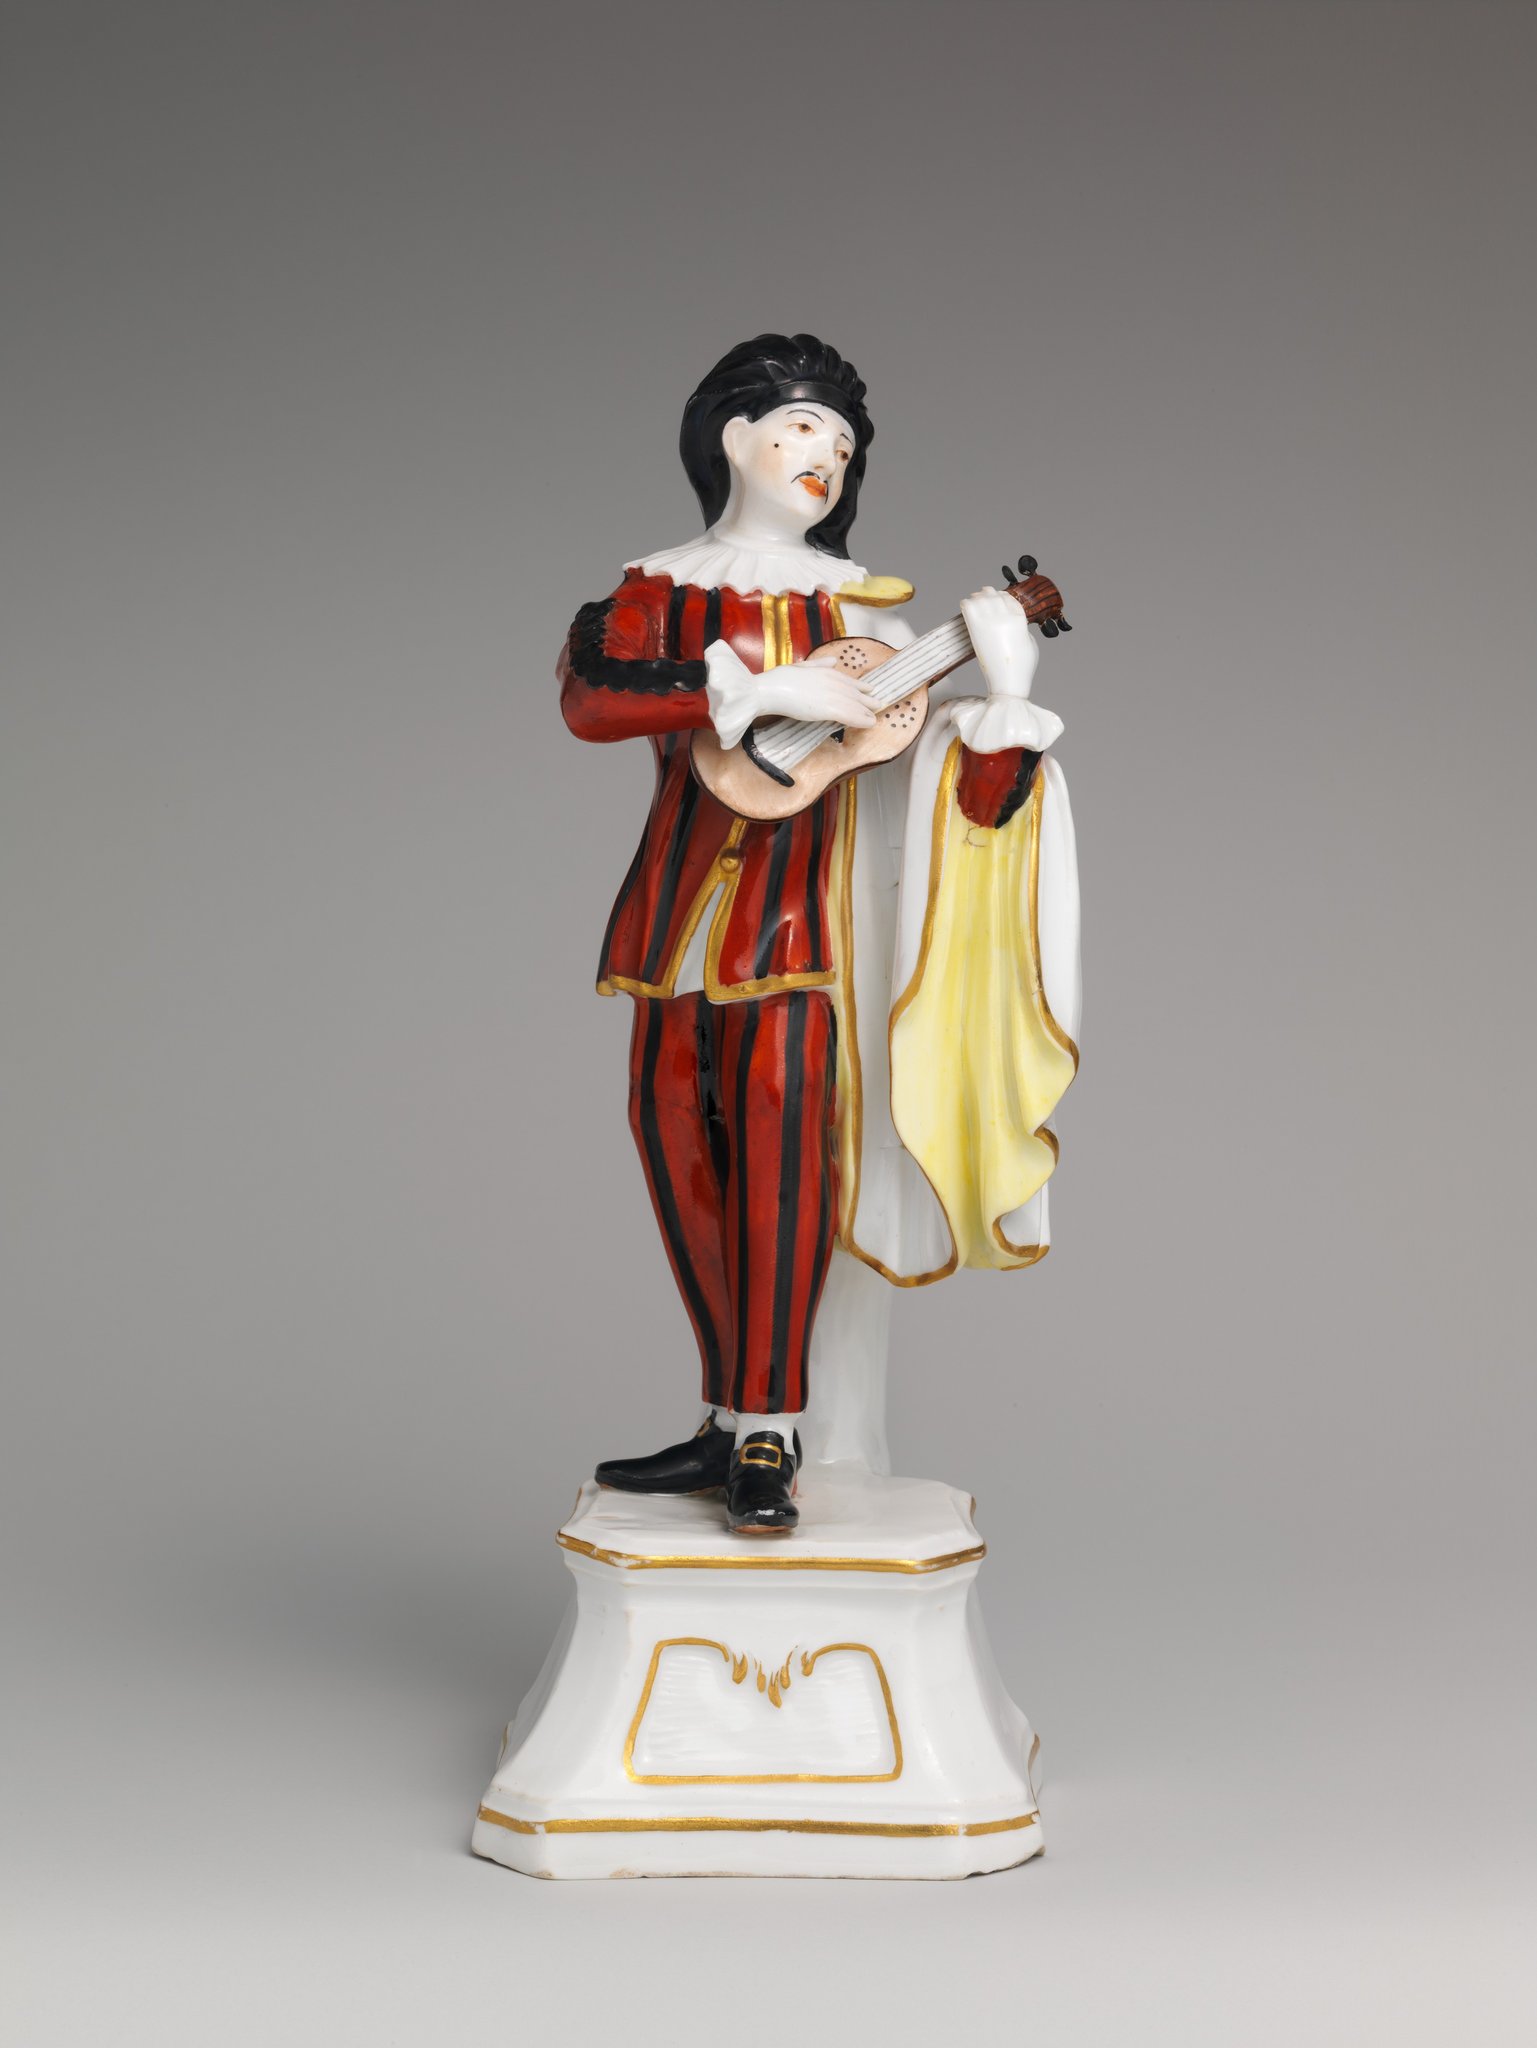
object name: figure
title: Bagolin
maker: höchst manufactory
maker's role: manufactory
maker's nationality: german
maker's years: 1746-1796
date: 1750-1753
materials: hard paste porcelain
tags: musical instruments,men